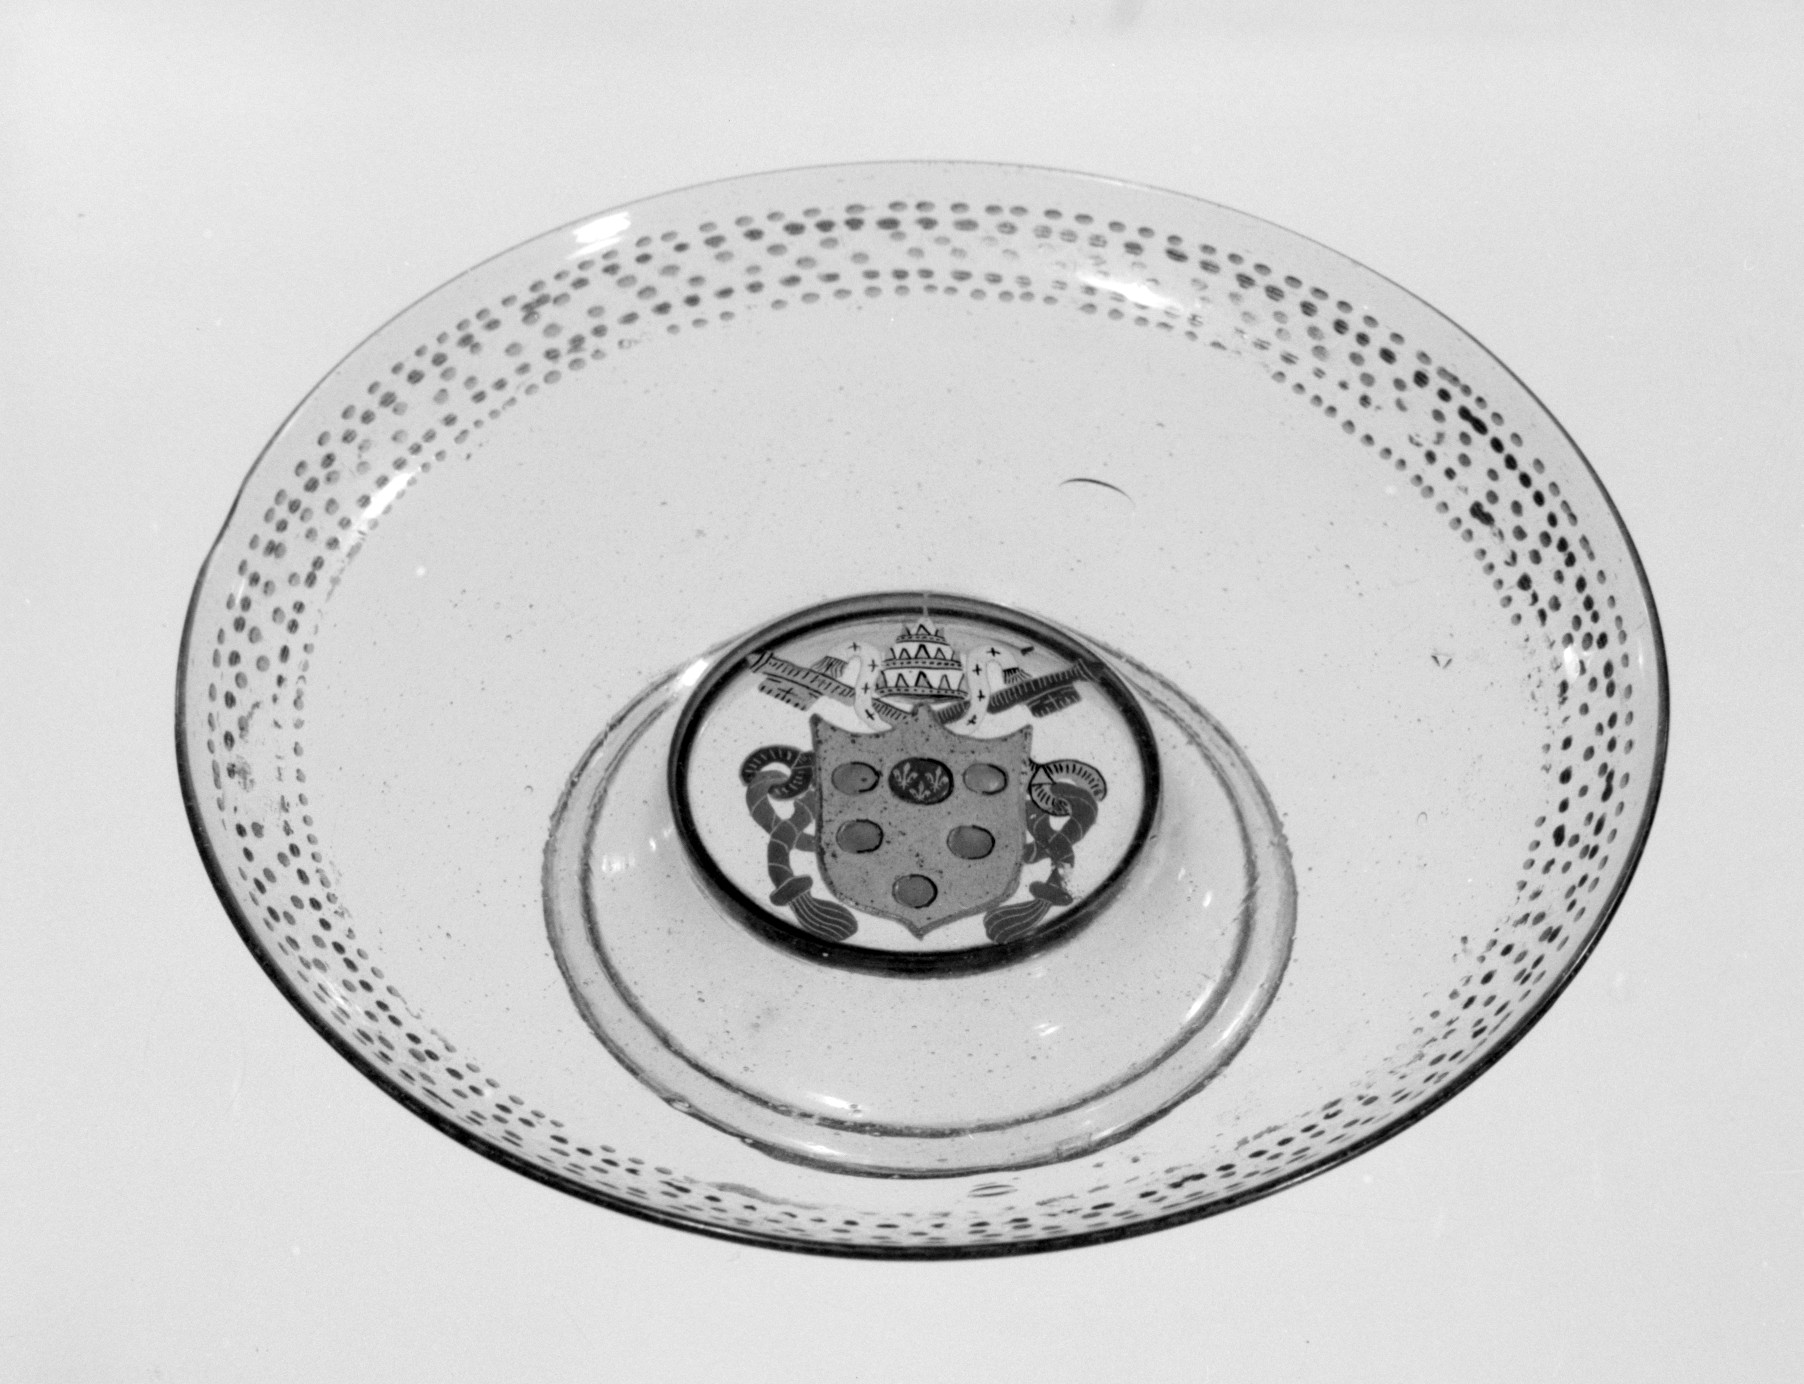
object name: tazza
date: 1513-1534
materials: glass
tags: coat of arms